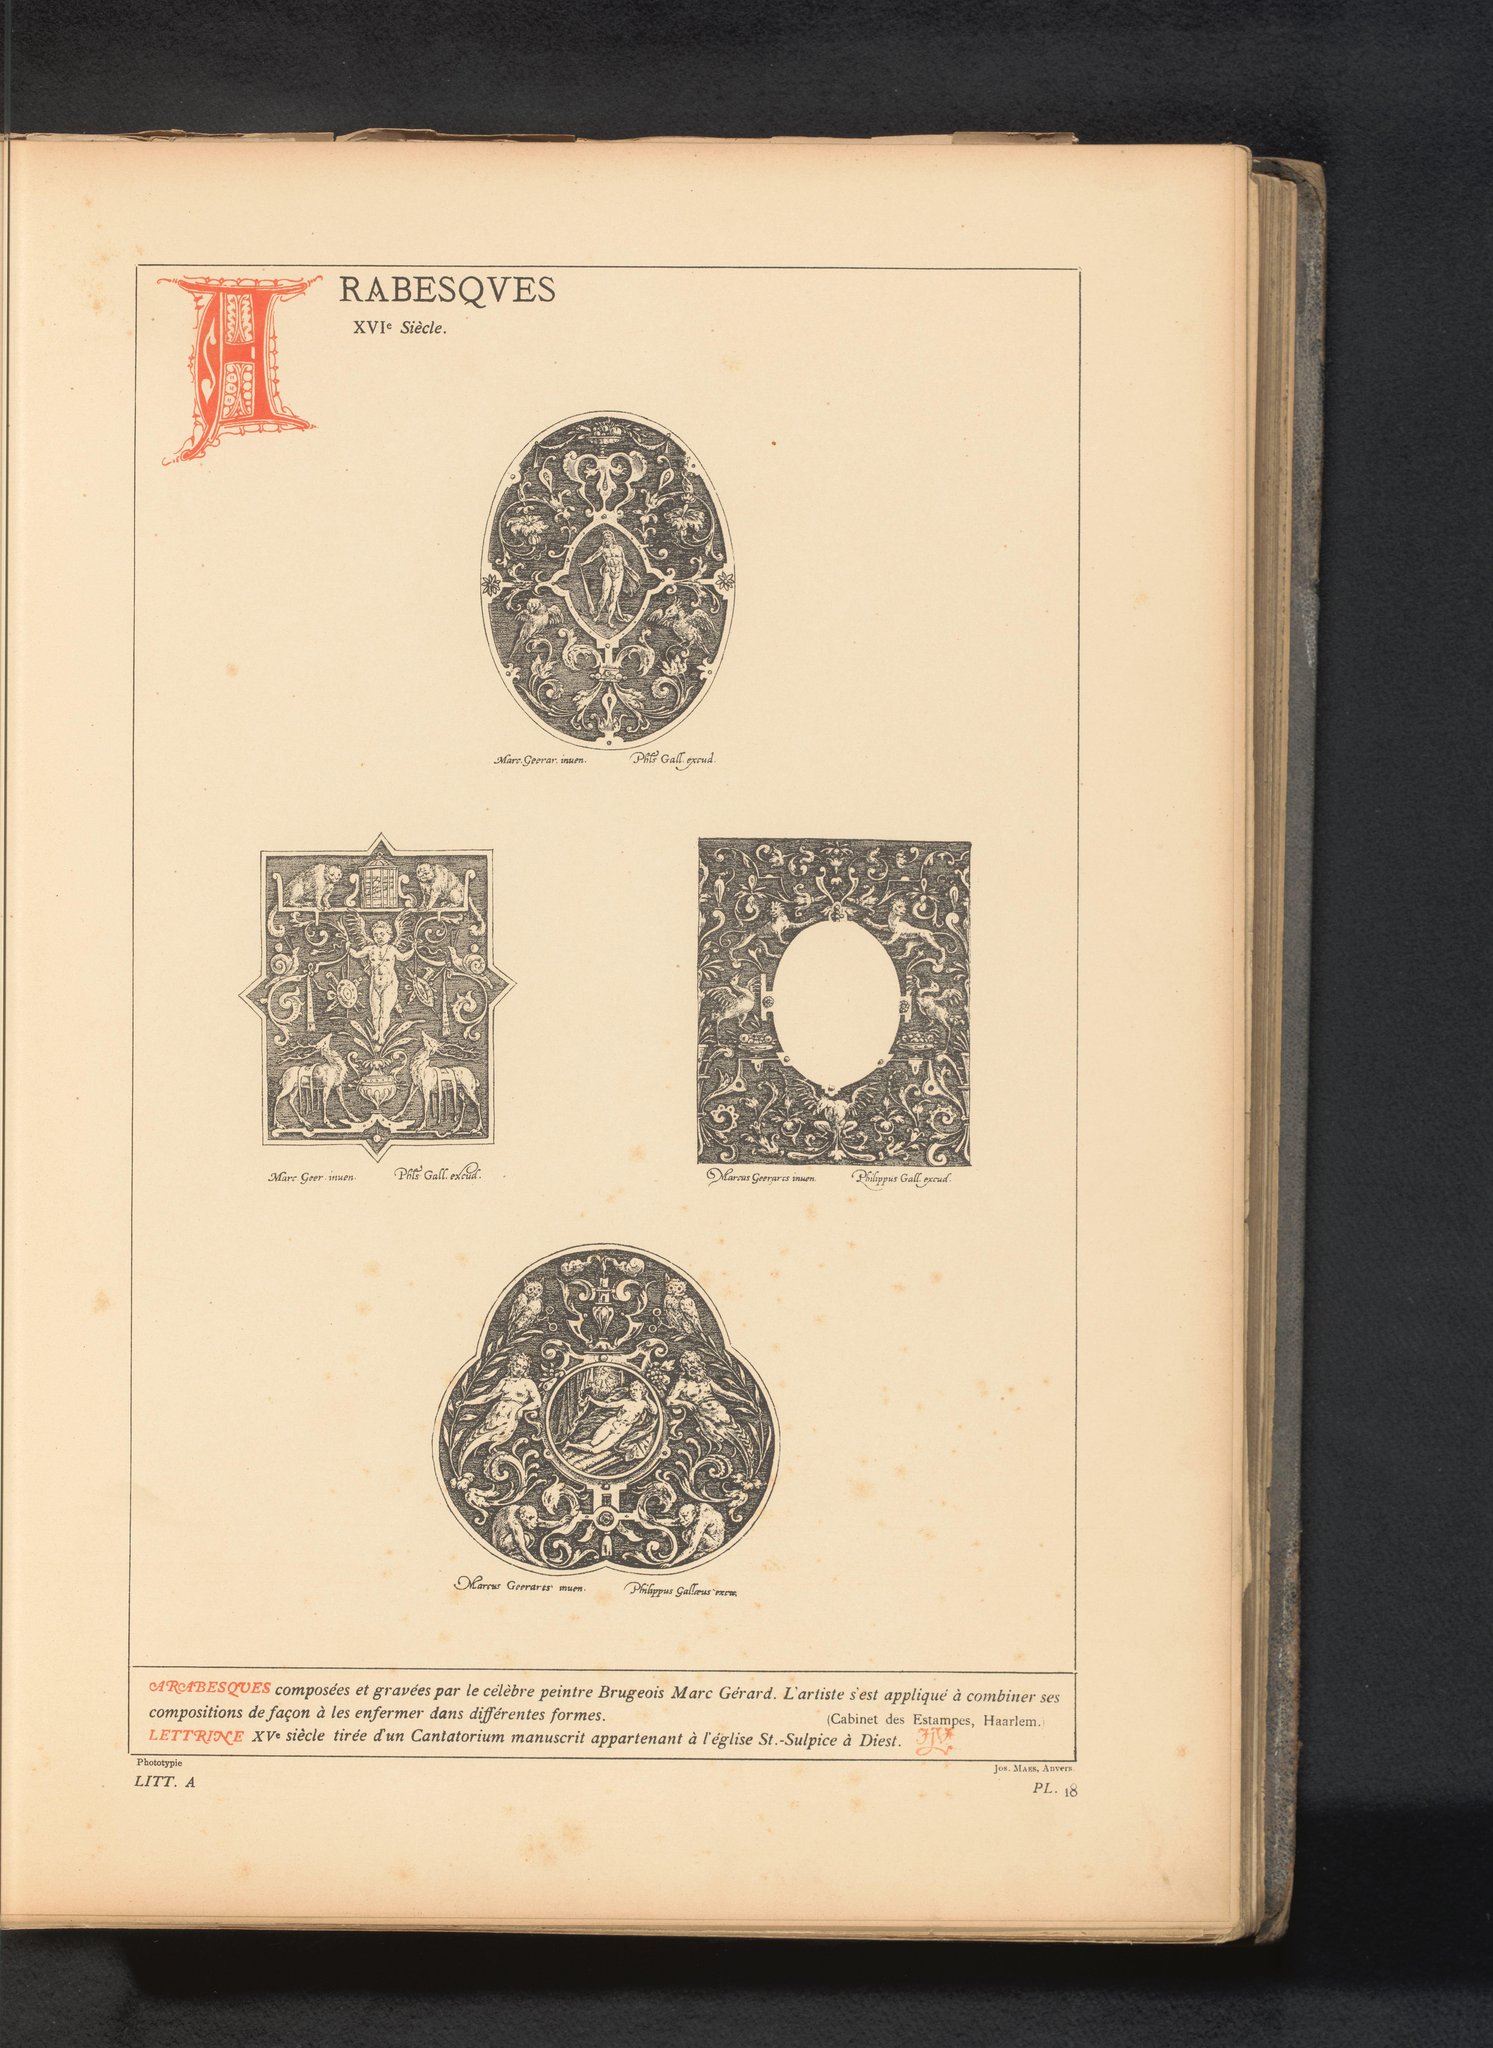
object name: page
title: Arabesques, XVIe Siècle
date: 1875-1880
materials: paper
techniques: photolithography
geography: antwerp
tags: animals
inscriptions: inscription: ‘LITT: A. - PL. 18’, inscription: ‘Arabesques composées et (...)’, monogram: ‘JJvY’